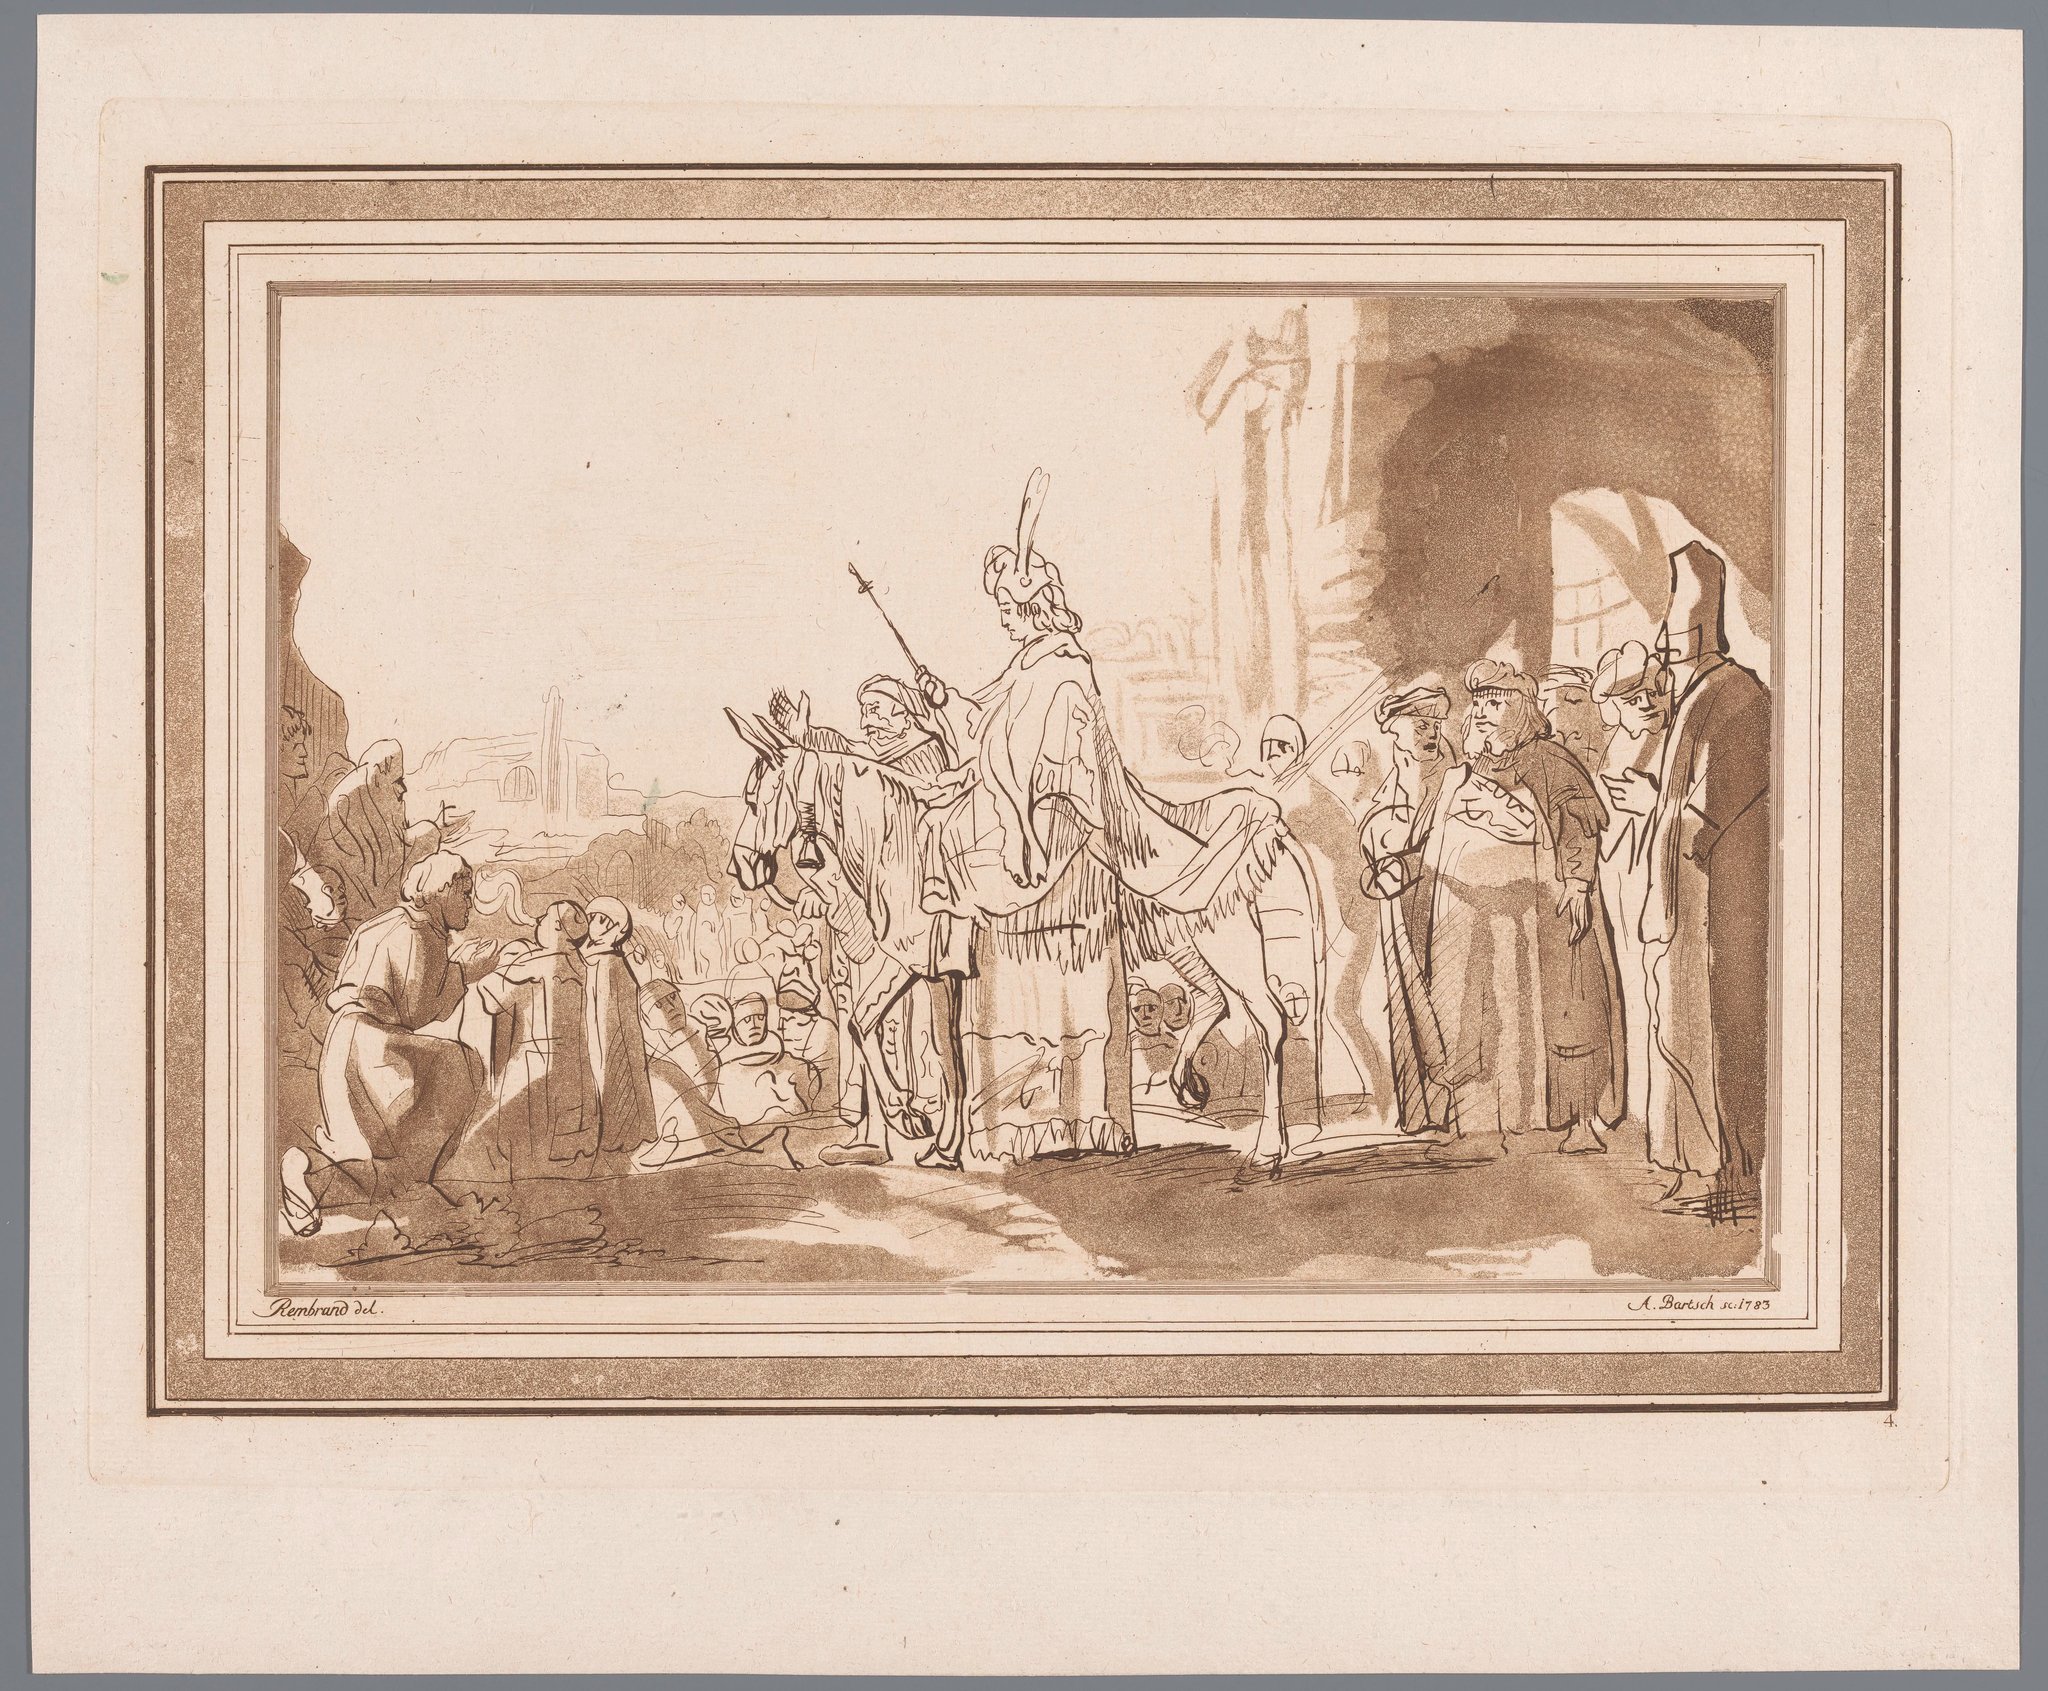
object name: print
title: Salomo rijdend op Davids ezel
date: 1783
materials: paper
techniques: aquatint, etching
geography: vienna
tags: solomon's entry into jerusalem as king: he rides on david's mule and all the people rejoice and blow their trumpets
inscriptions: collector's mark: Lugt 2228